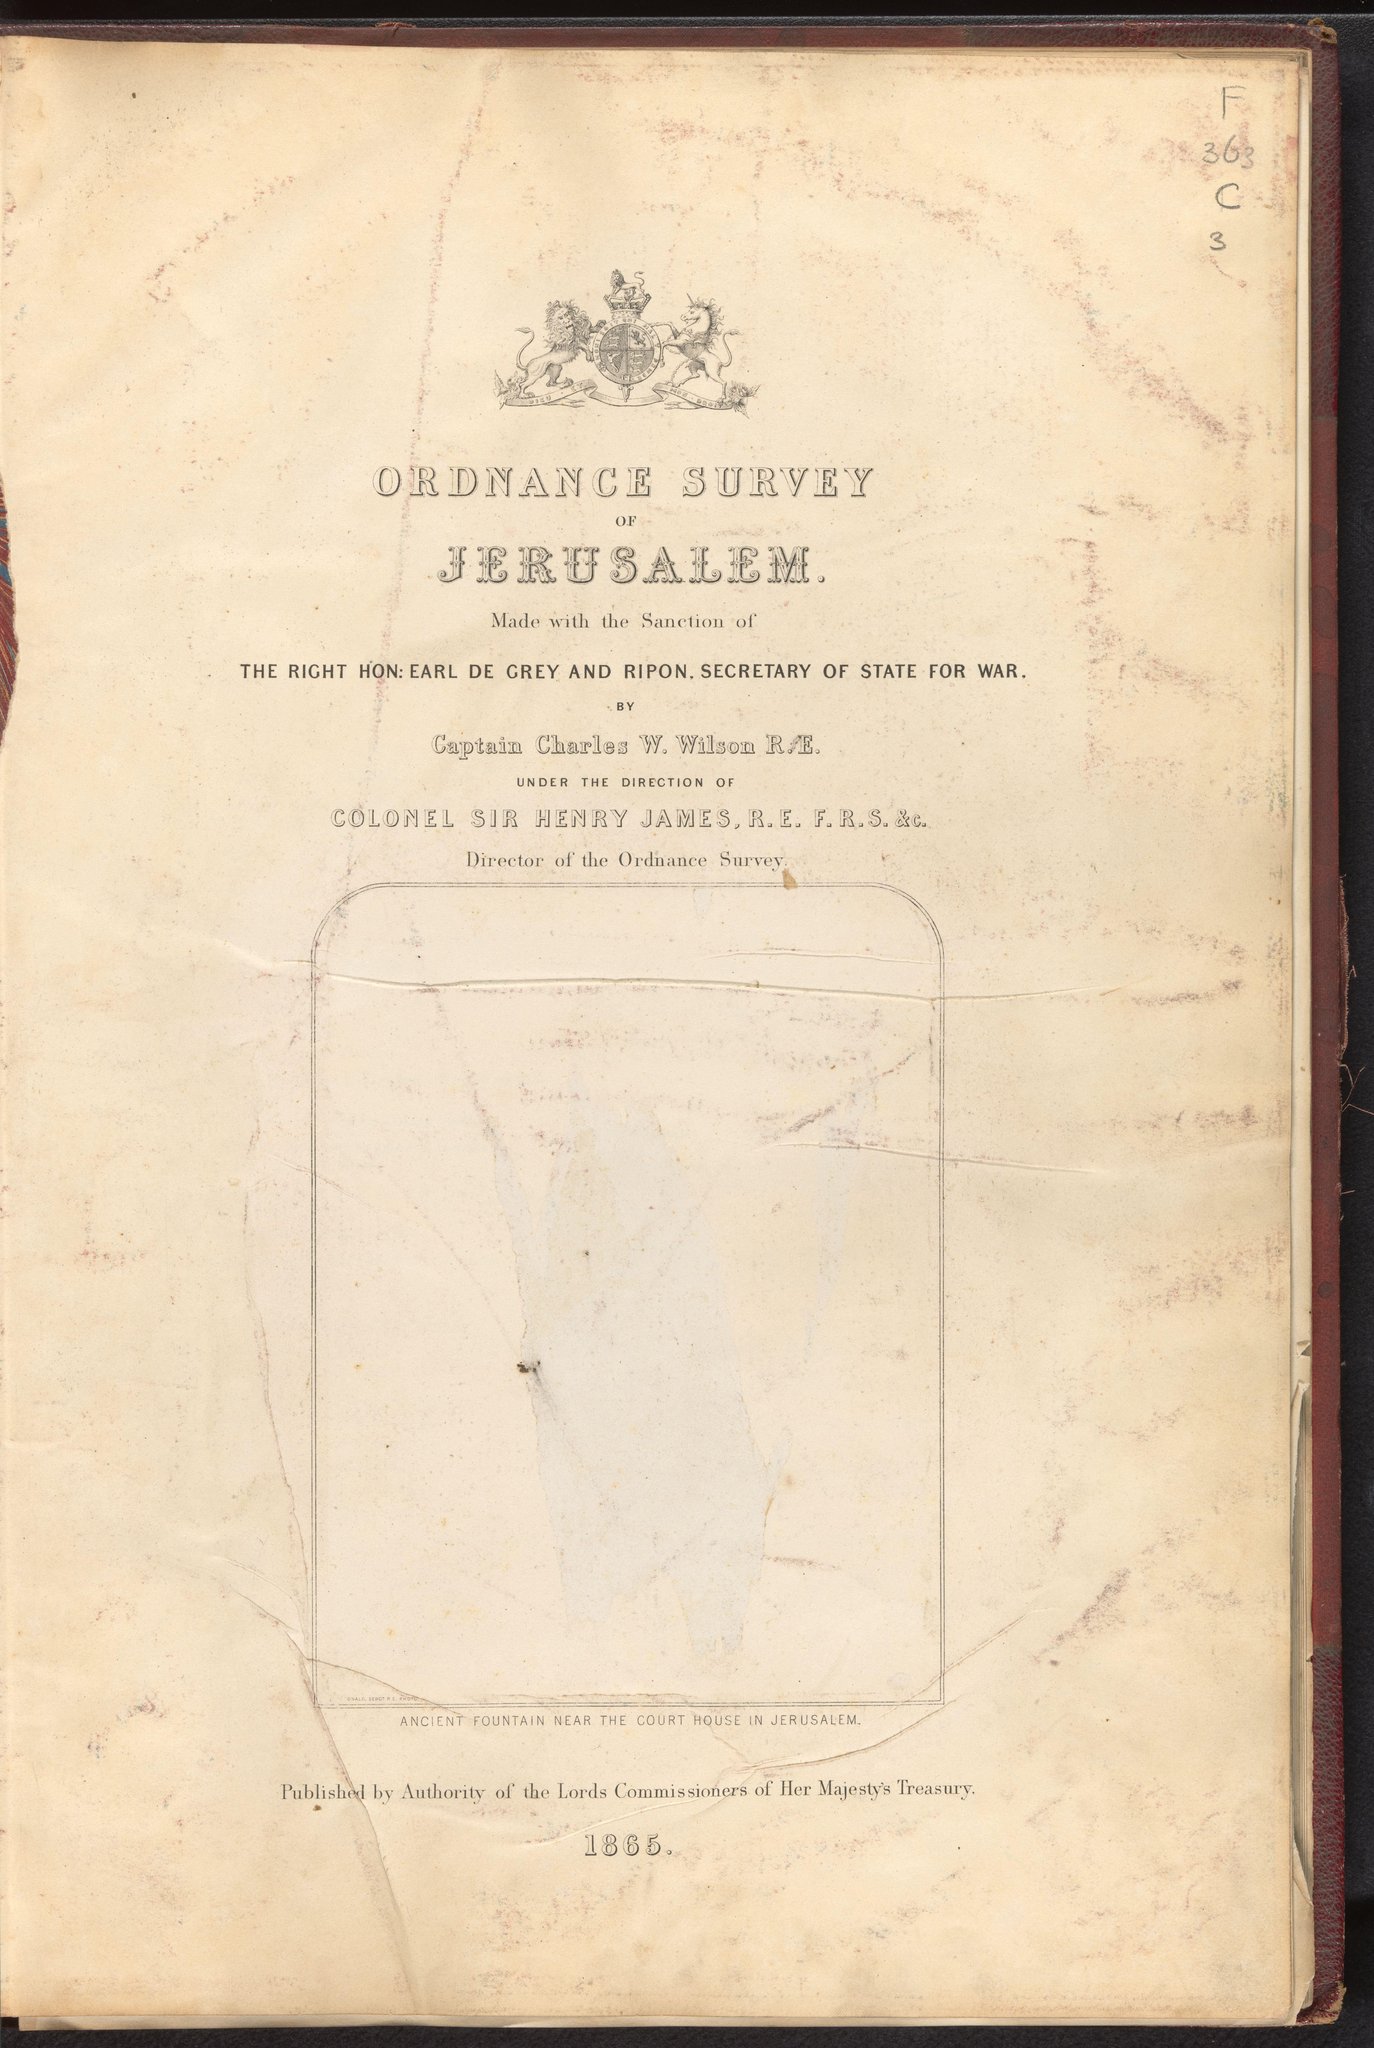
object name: book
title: Ordnance survey of Jerusalem : made with the sanction of the Right Hon. Earl de Grey and Ripon, Secretary of State for War / by Charles W. Wilson, under the direction of Henry James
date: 1865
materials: cardboard, leather, linen, paper, photographic support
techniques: albumen print, marbled paper, printing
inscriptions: retailer's mark: ‘ORDNANCE MAPS/ ENGRAVING/ PRINTING/ BOOKS.GLOBES. STATIONERY/ STANFORD,/ 6, Charing Cross,/ LONDON./ ADMIRALTY CHARTS’, annotation: ‘niet compleet:/ Er ontbreken: Foto titelpagina/ Foto 1b/ pag.: 9, 25, 30, 39 t/m 43’, date: ‘JULY/ 1992’